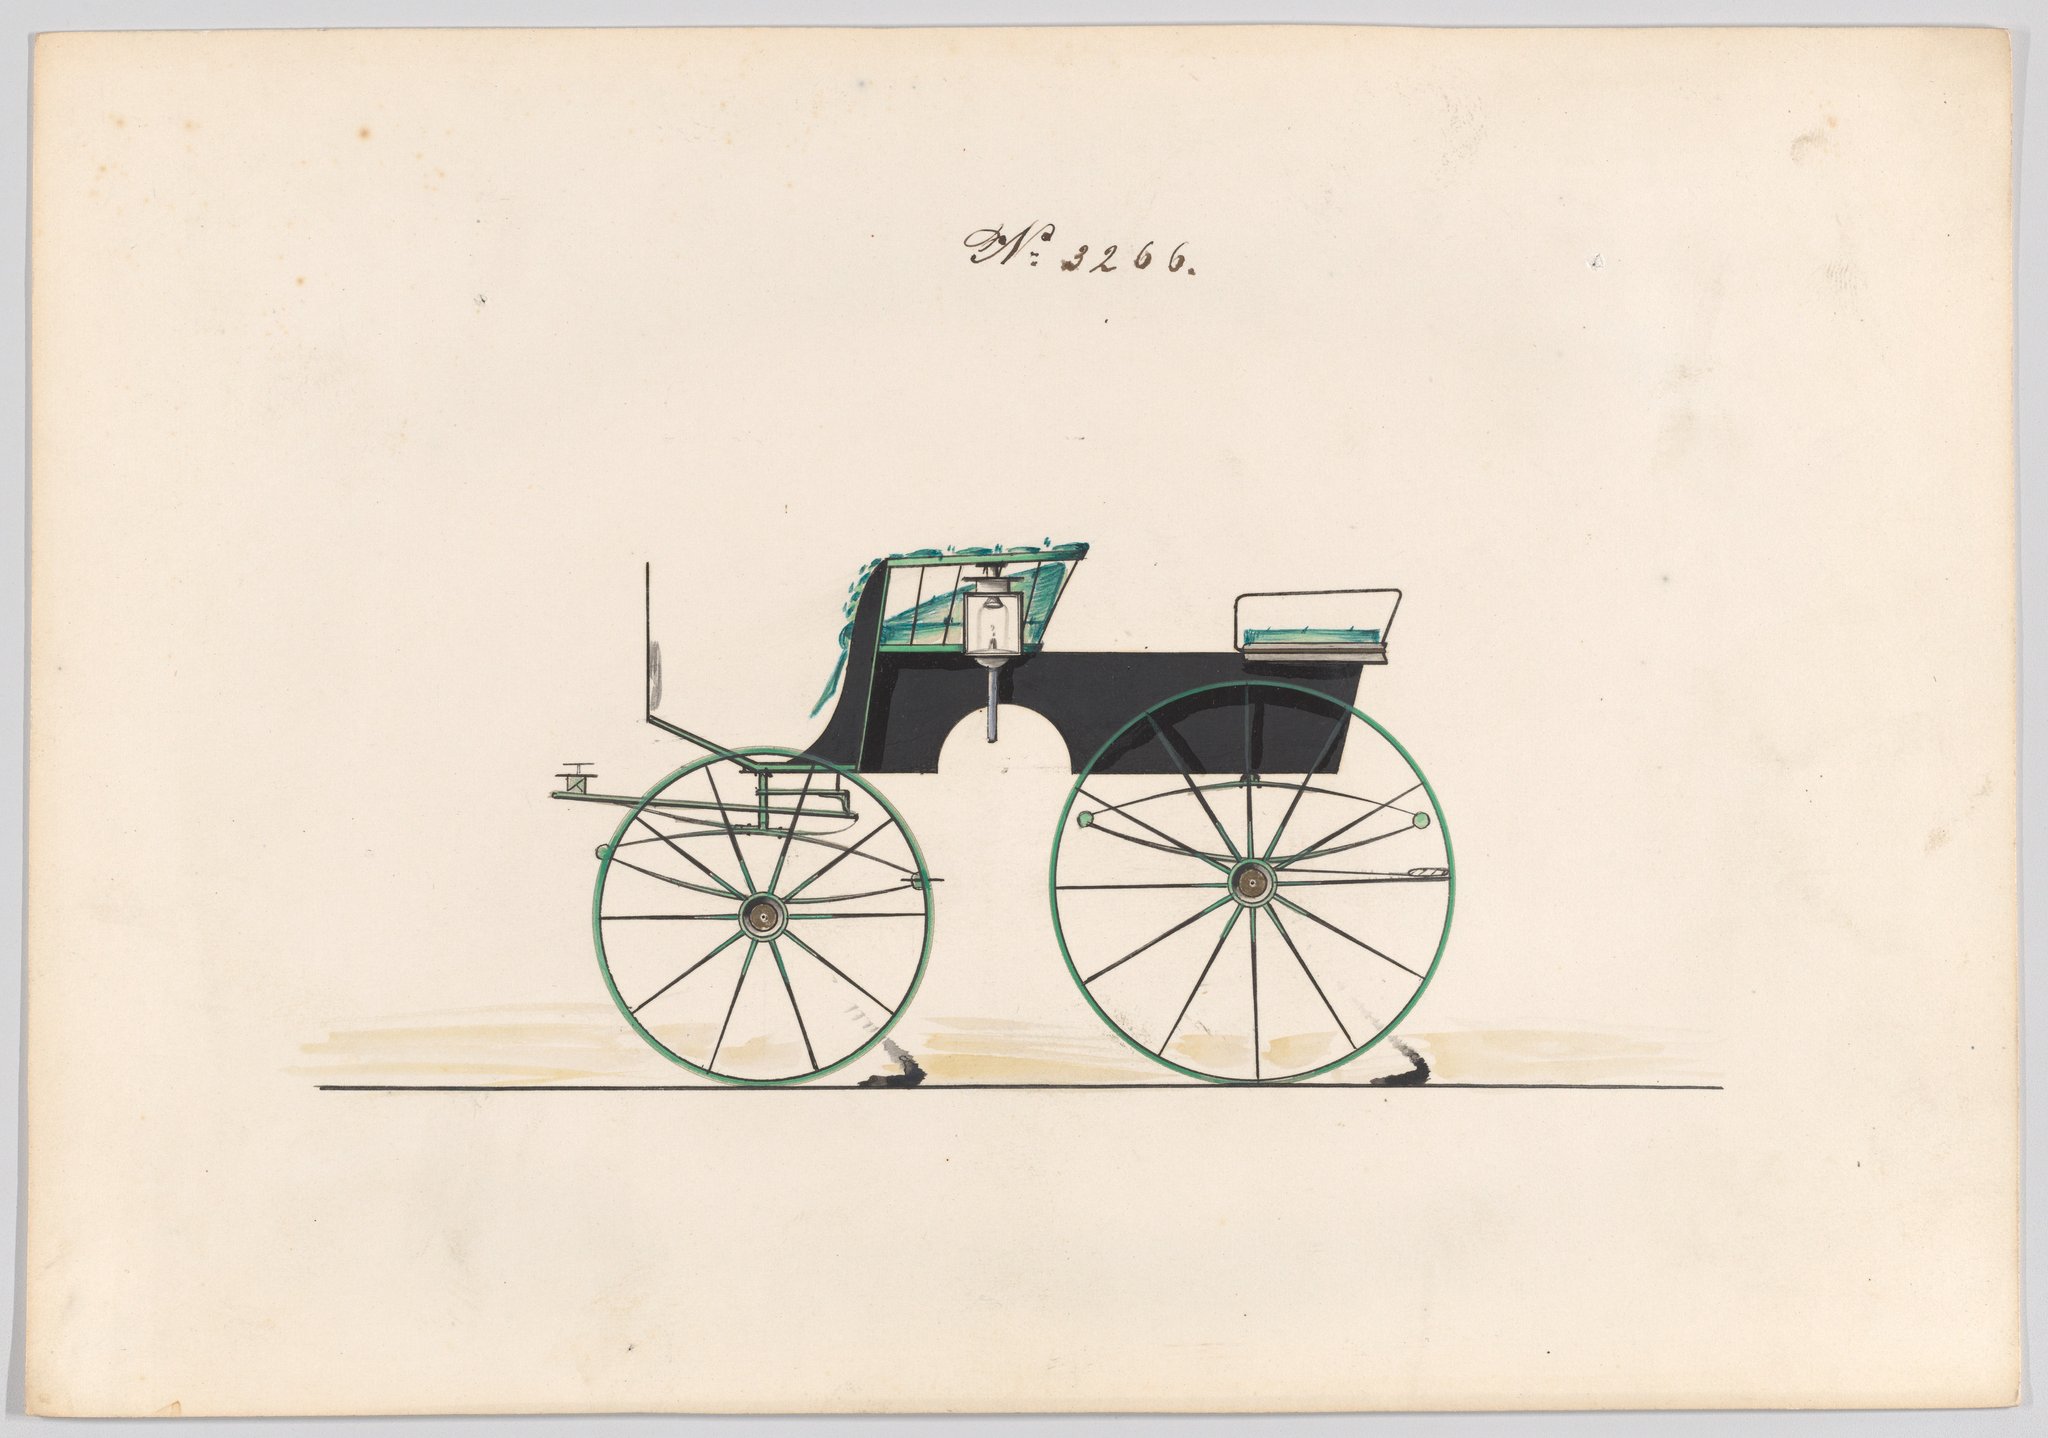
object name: drawing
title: Design for T-Cart, no. 3266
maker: brewster & co.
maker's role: manufacturer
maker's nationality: american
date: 1876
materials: gouache, gum arabic, ink, watercolor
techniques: pen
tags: carriages